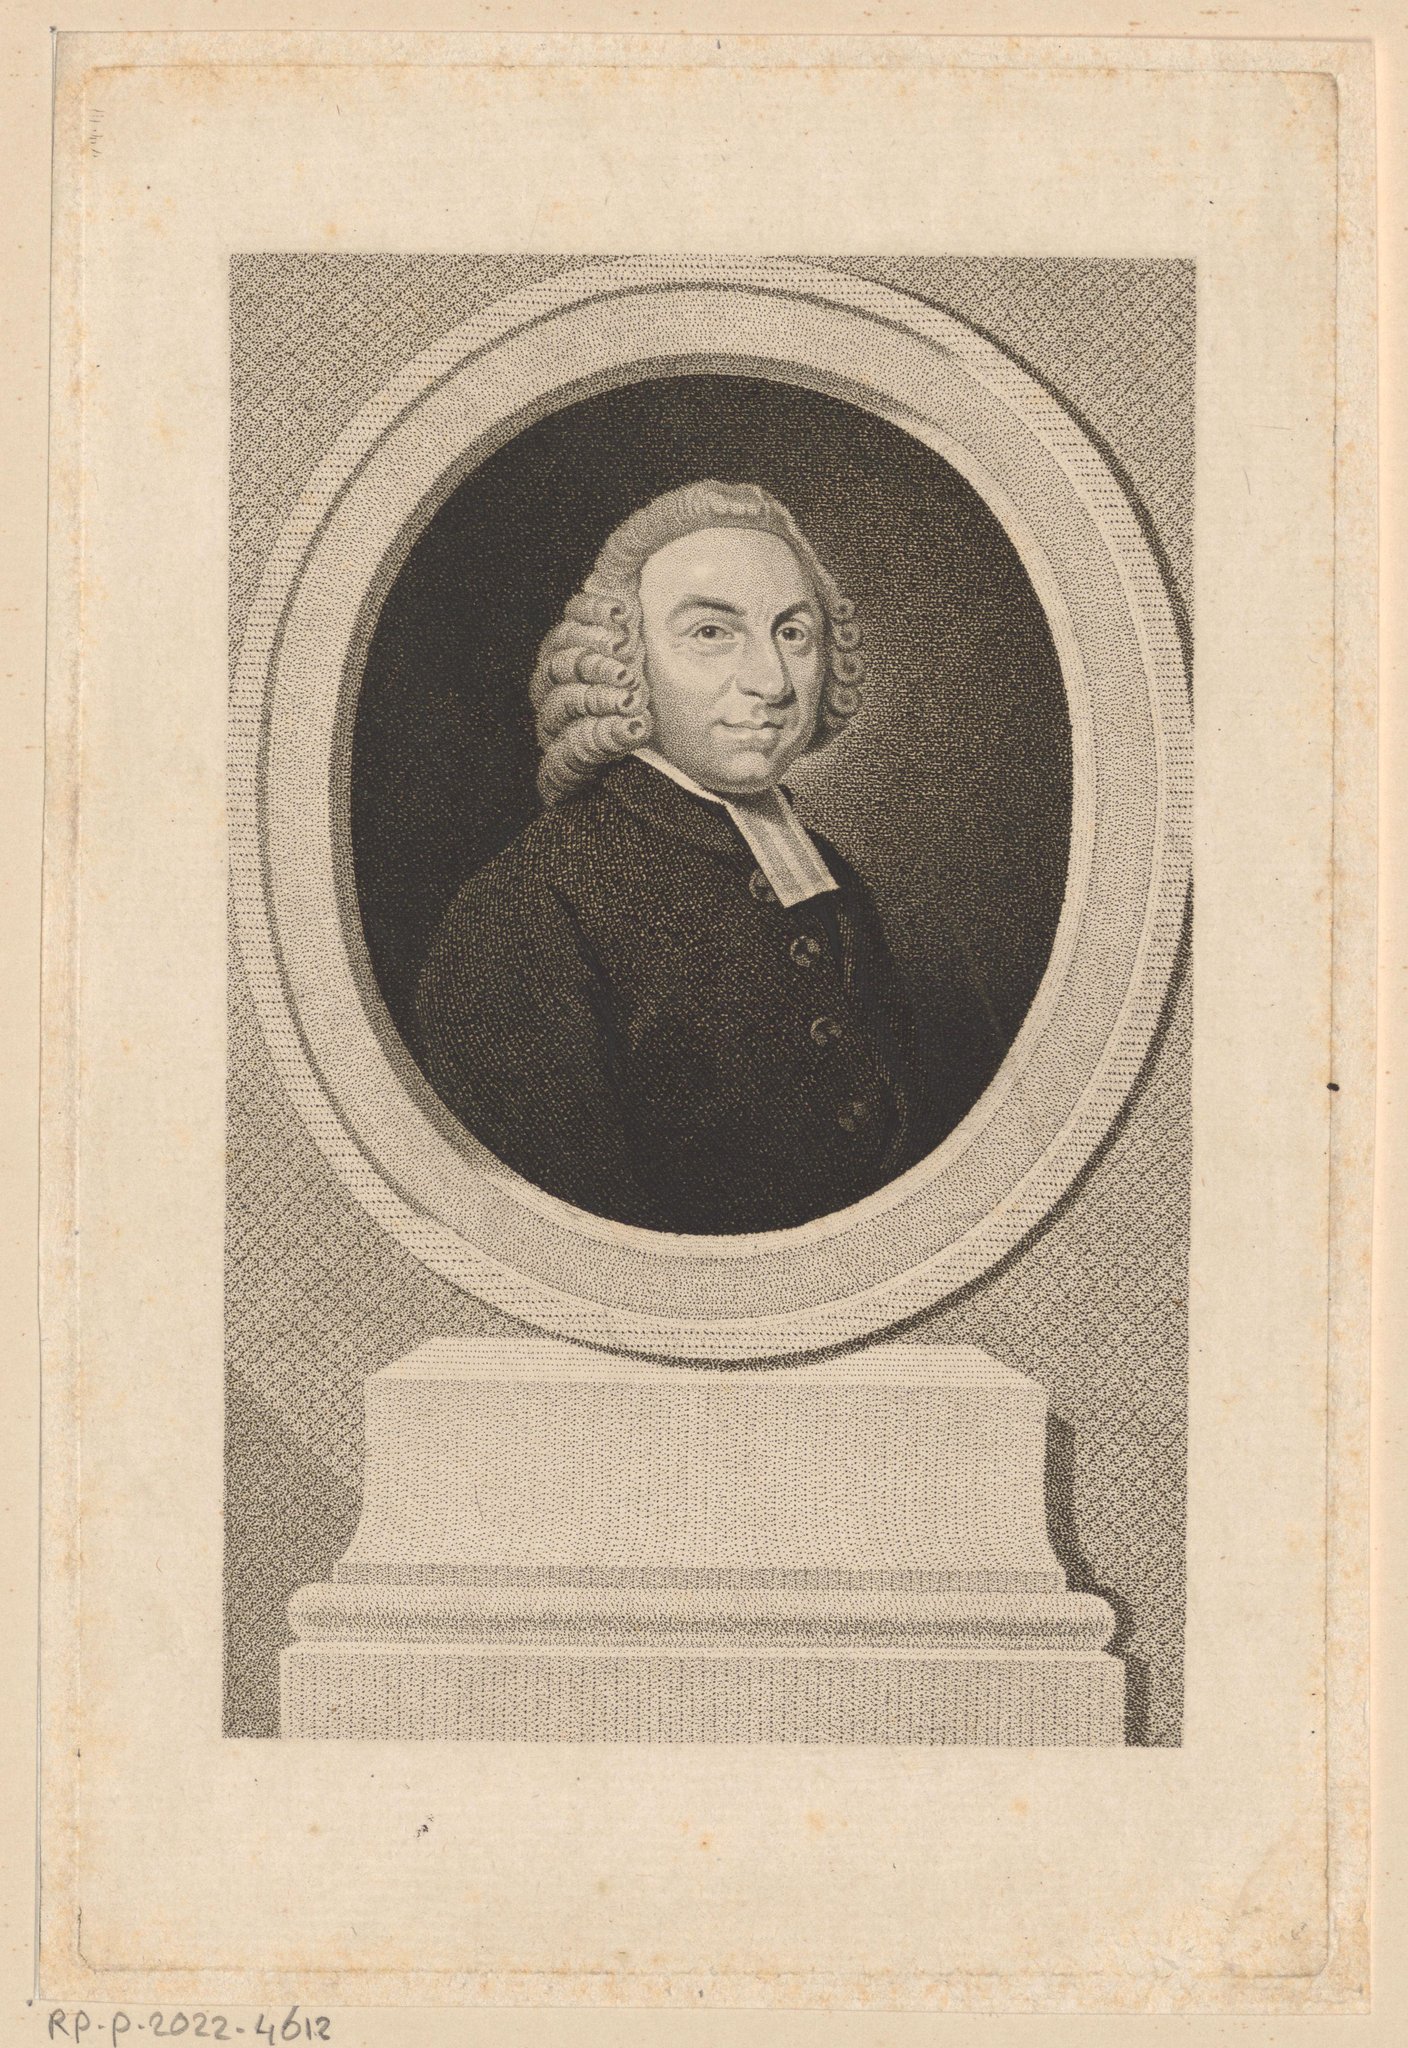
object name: print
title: Portret van Hendrik Husly Viervant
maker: Anonymous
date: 1807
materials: paper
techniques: etching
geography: amsterdam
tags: amsterdam, theologian, historical persons